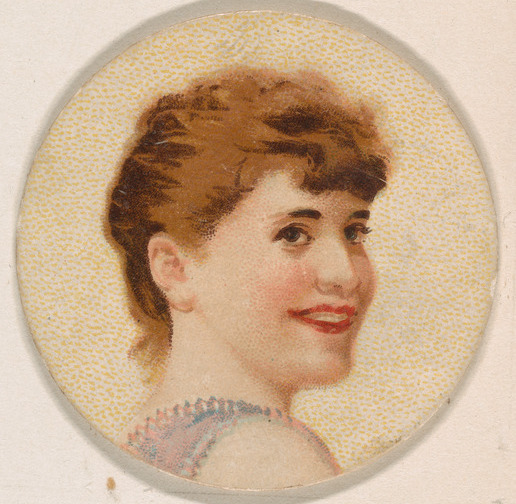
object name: print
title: Portrait of woman, from the Novelties series (N228, Type 1) issued by Kinney Bros.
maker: kinney brothers tobacco company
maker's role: publisher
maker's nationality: american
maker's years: 1869-2011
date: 1889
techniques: color lithograph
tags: portraits,women